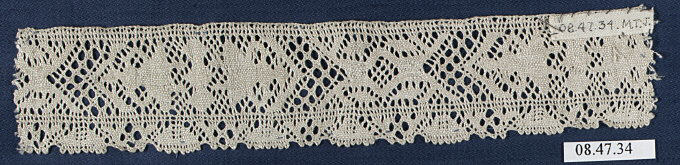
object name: fragment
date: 1801-1900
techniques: lace